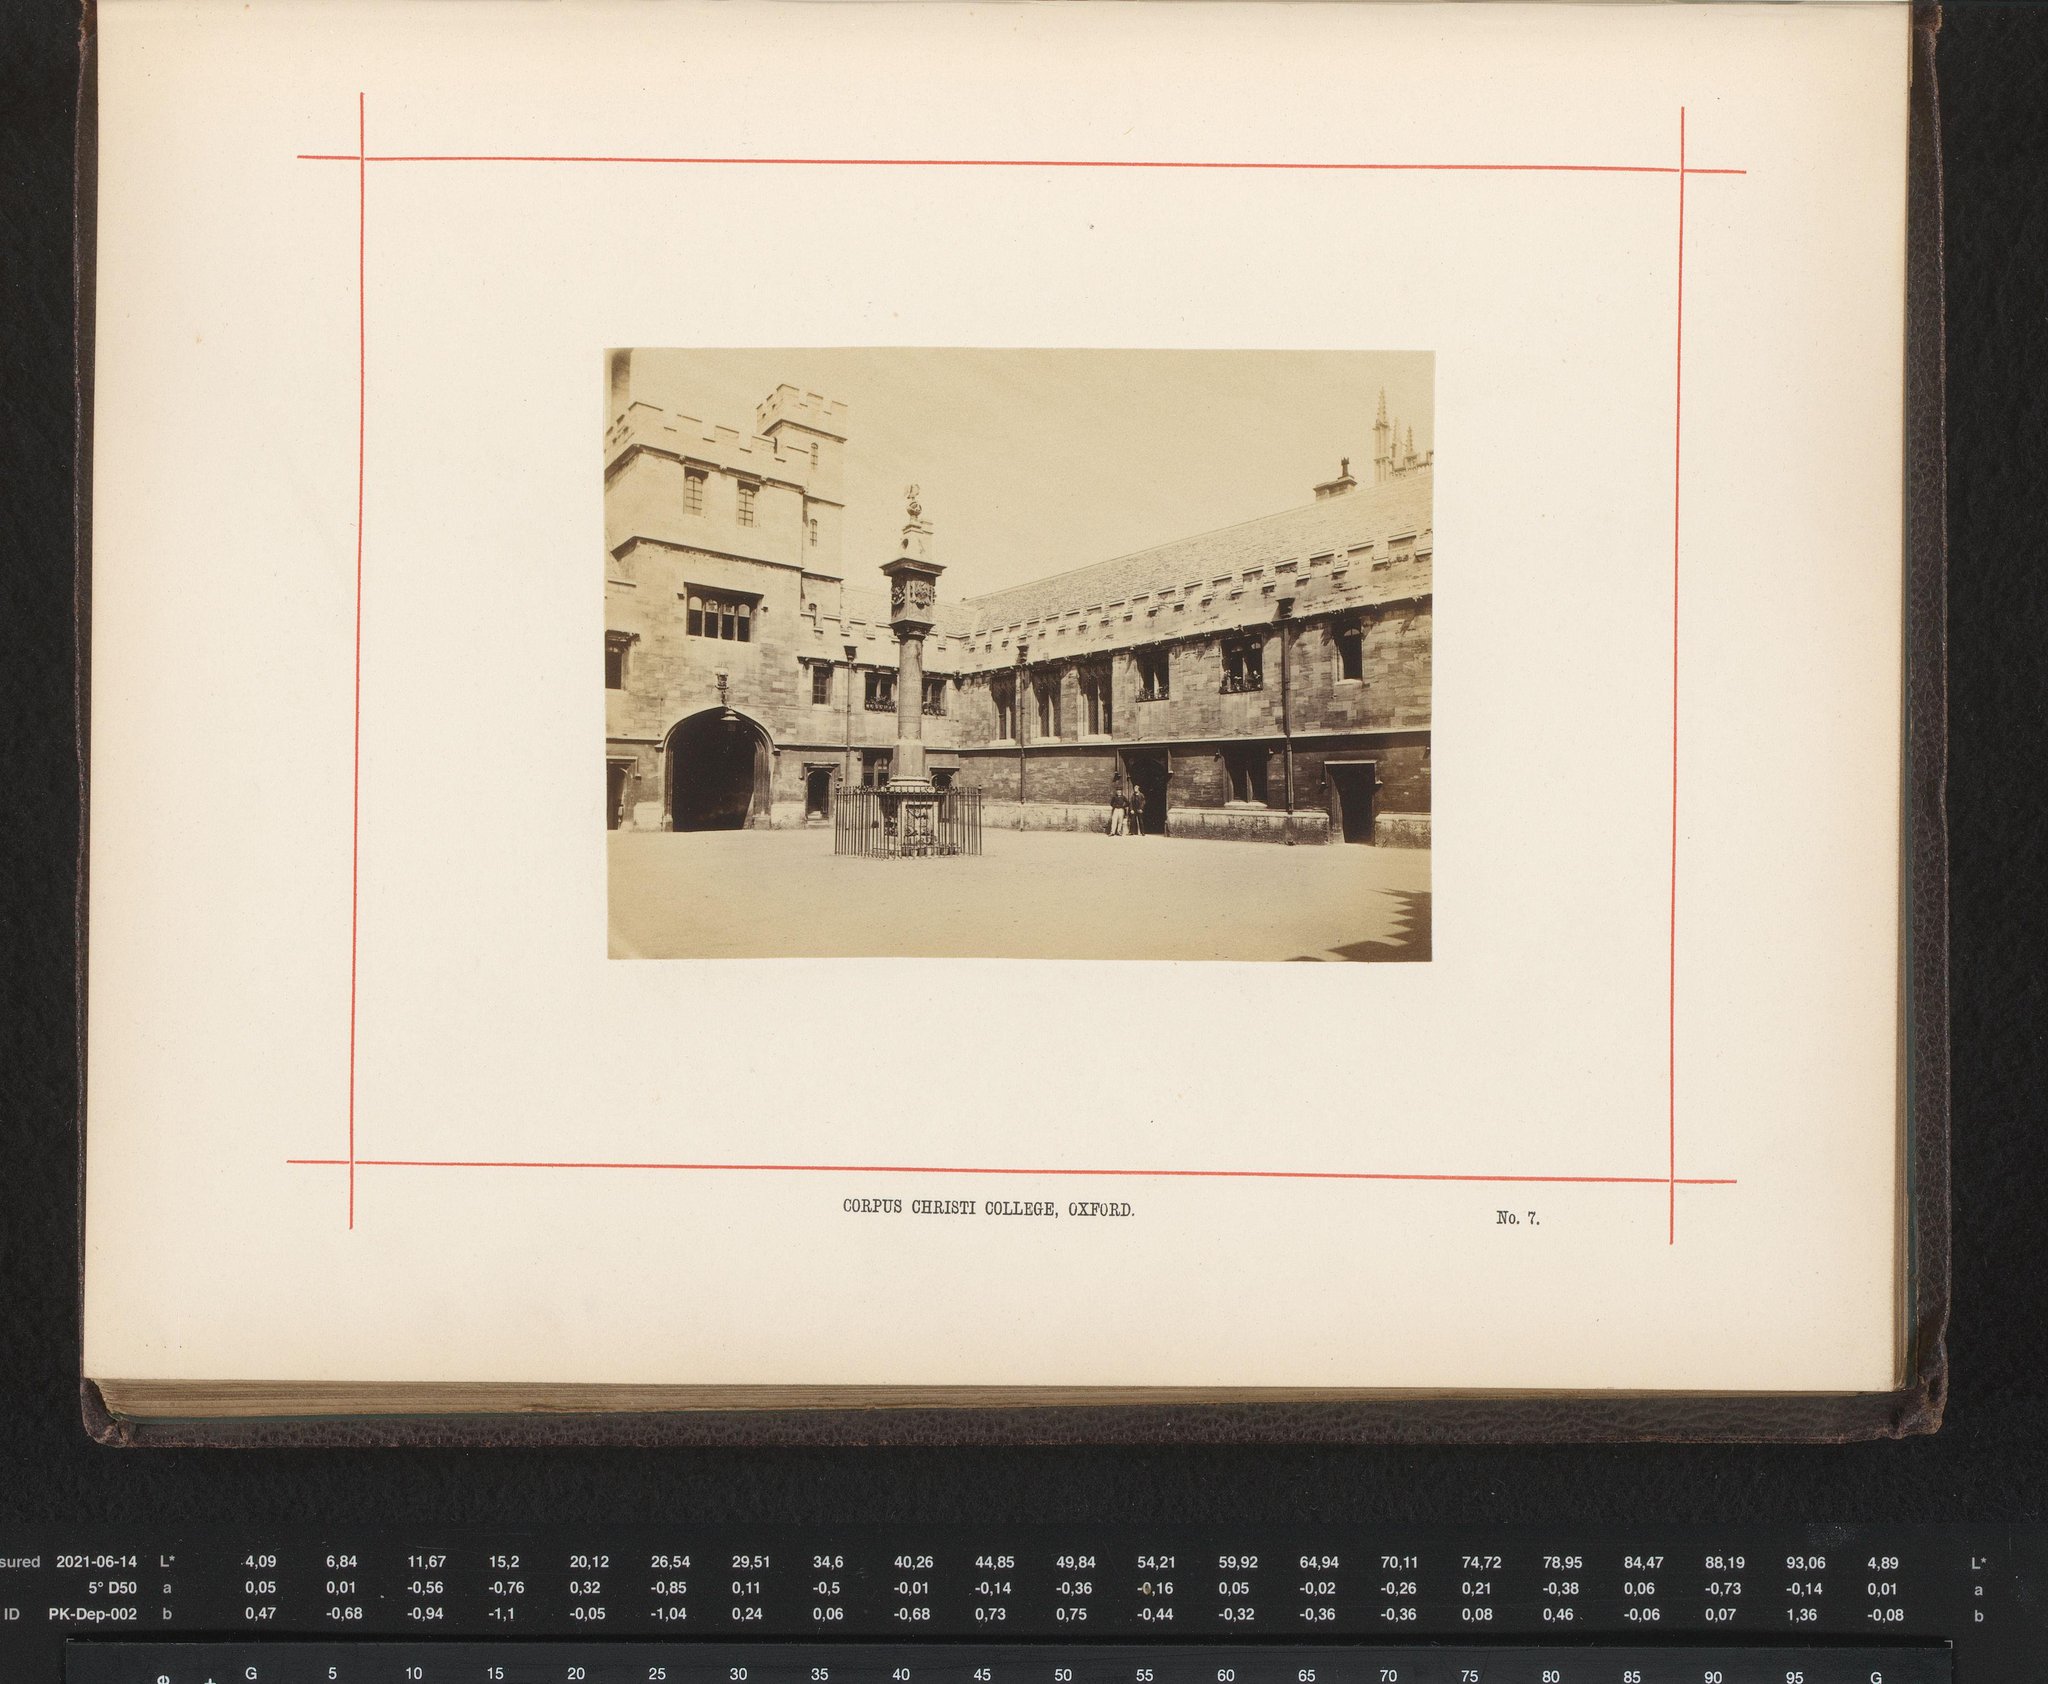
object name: page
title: Binnenplaats van Corpus Christi College in Oxford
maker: william savage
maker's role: fotograaf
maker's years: 1817-1887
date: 1861-1866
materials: paper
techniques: albumen print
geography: oxford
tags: university building, college, courtyard